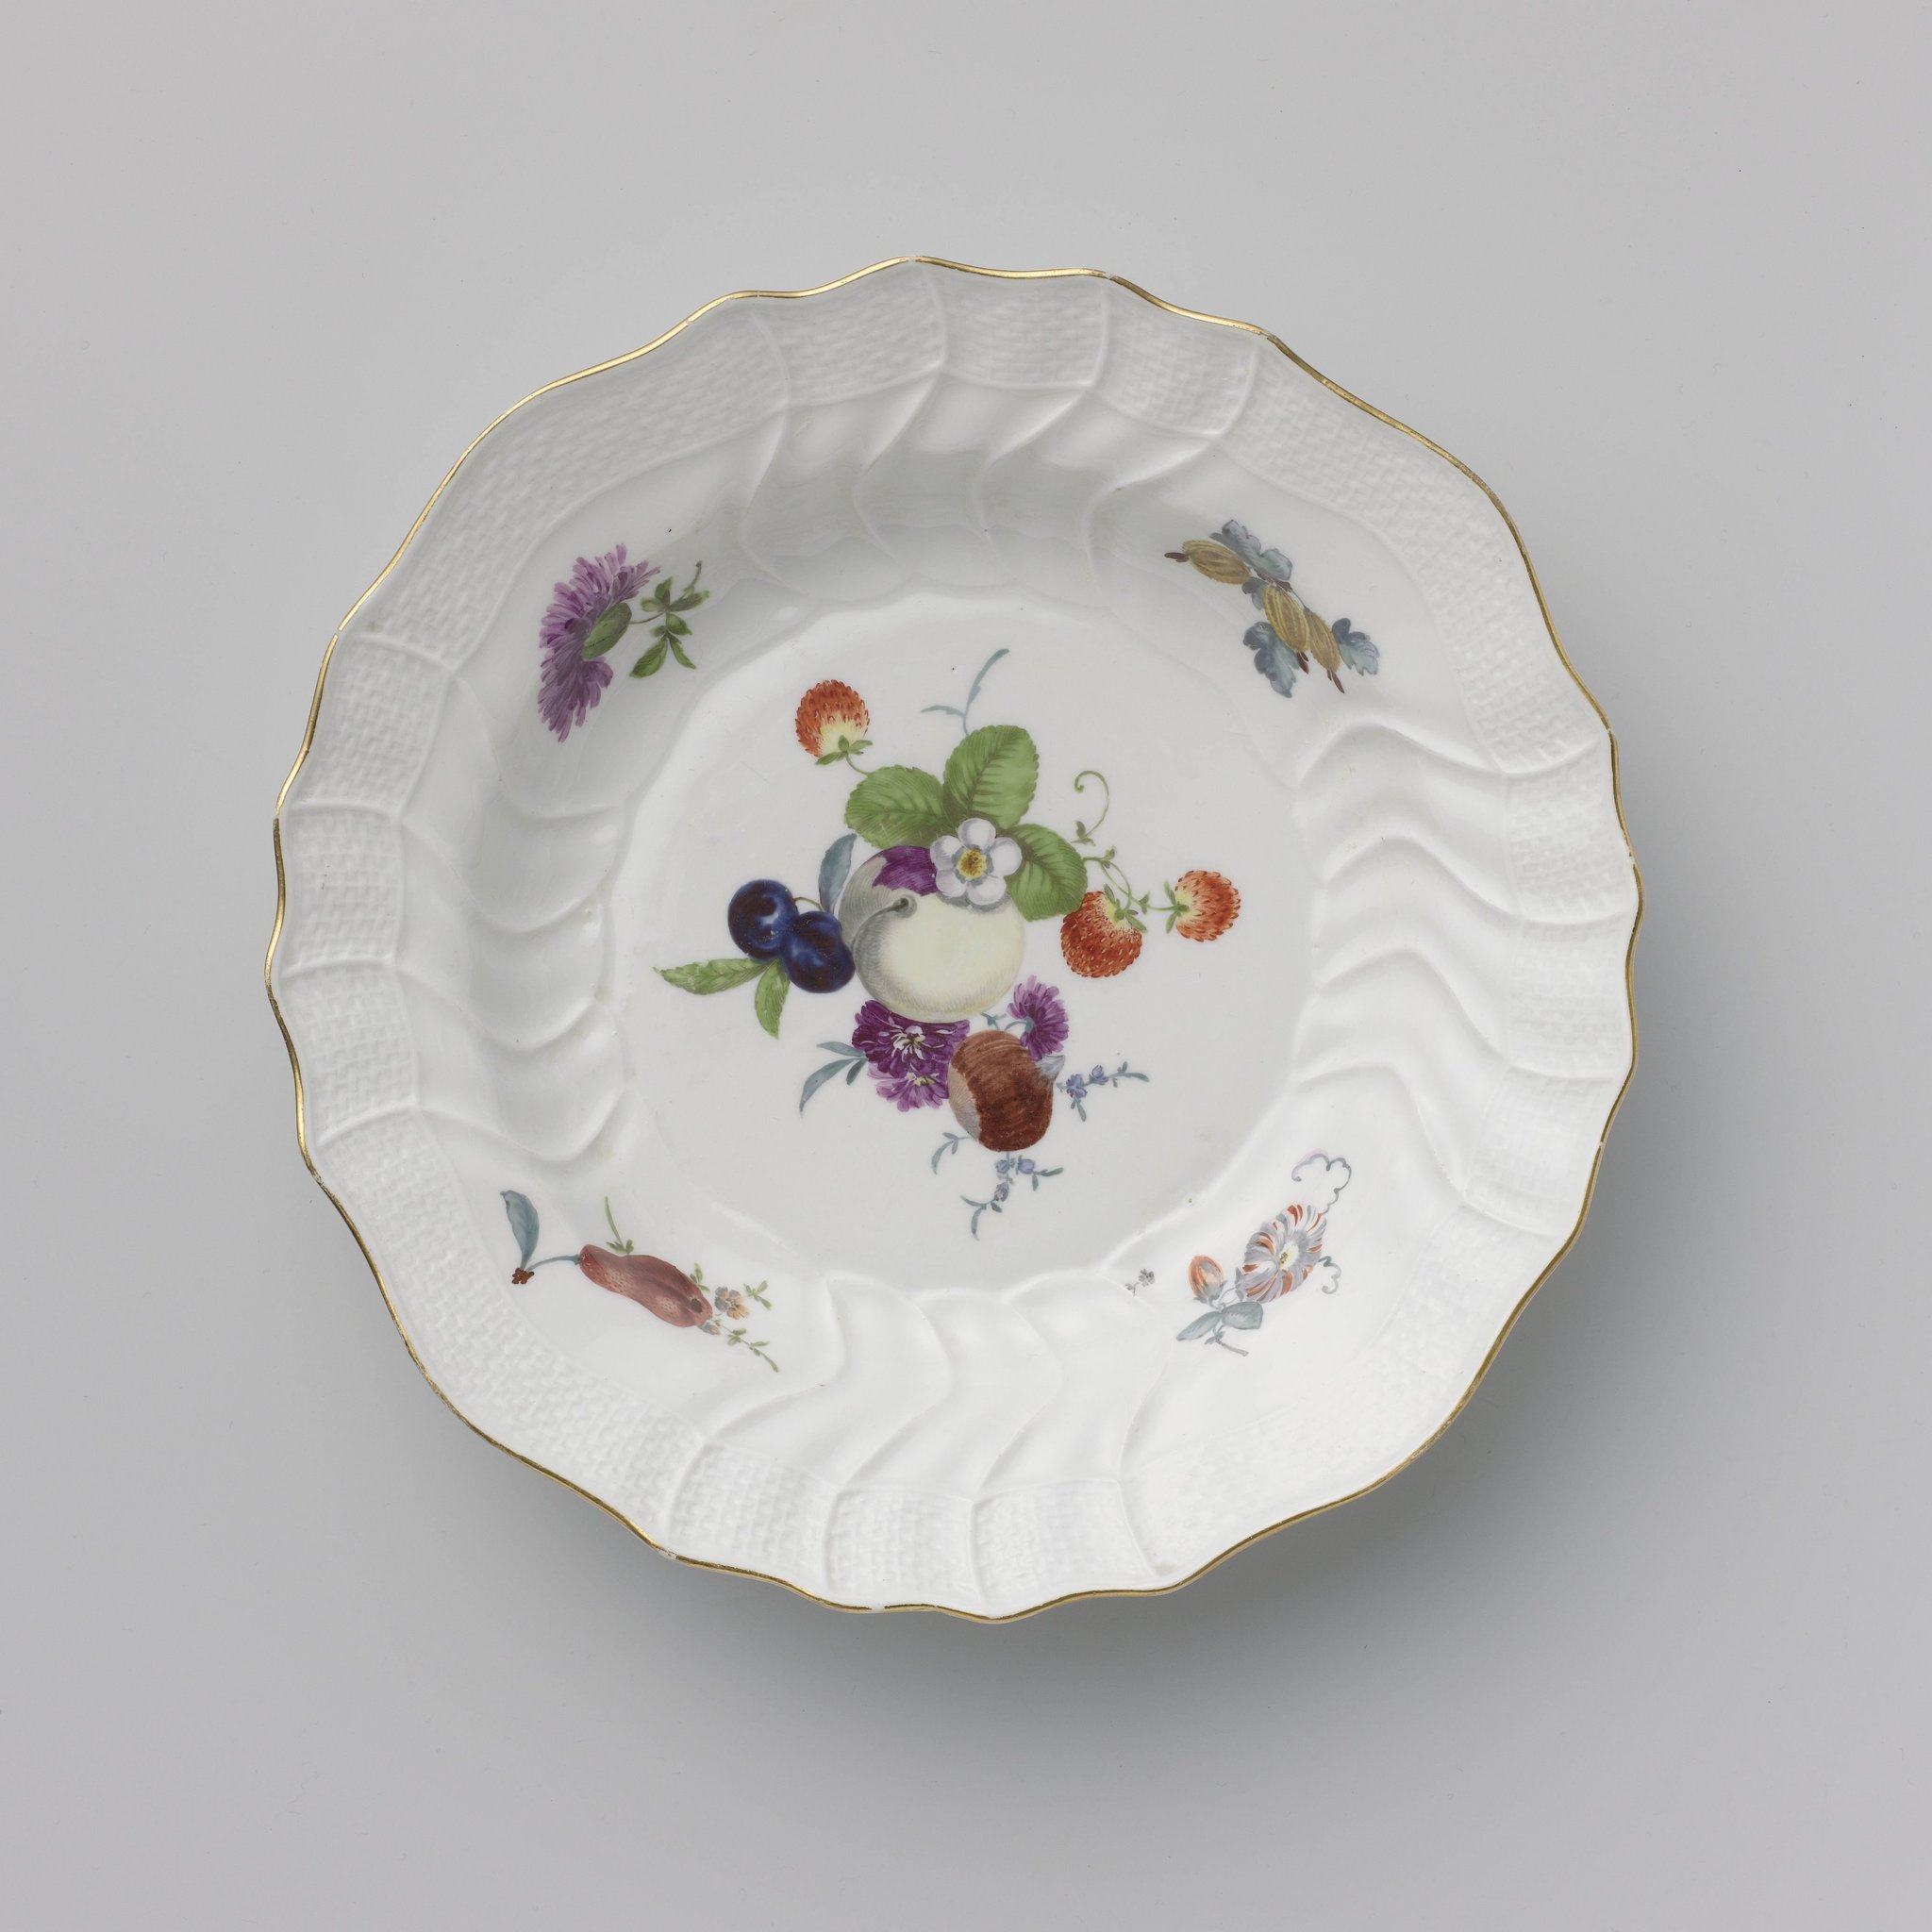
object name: soup plate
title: Bord, veelkleurig beschilderd met Deutsche Blumen, insekten en vruchten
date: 1750-1760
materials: porcelain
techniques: painted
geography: meissen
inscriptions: factory mark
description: Rond soepbord van beschilderd porselein. Het bord is beschilderd met Deutsche Blumen, insekten en vruchten. De rand is in reliëf versierd met het Neuozier-patroon. Het bord is gemerkt en hoort bij een servies (BK-17474-1 t/m BK-17474-253).